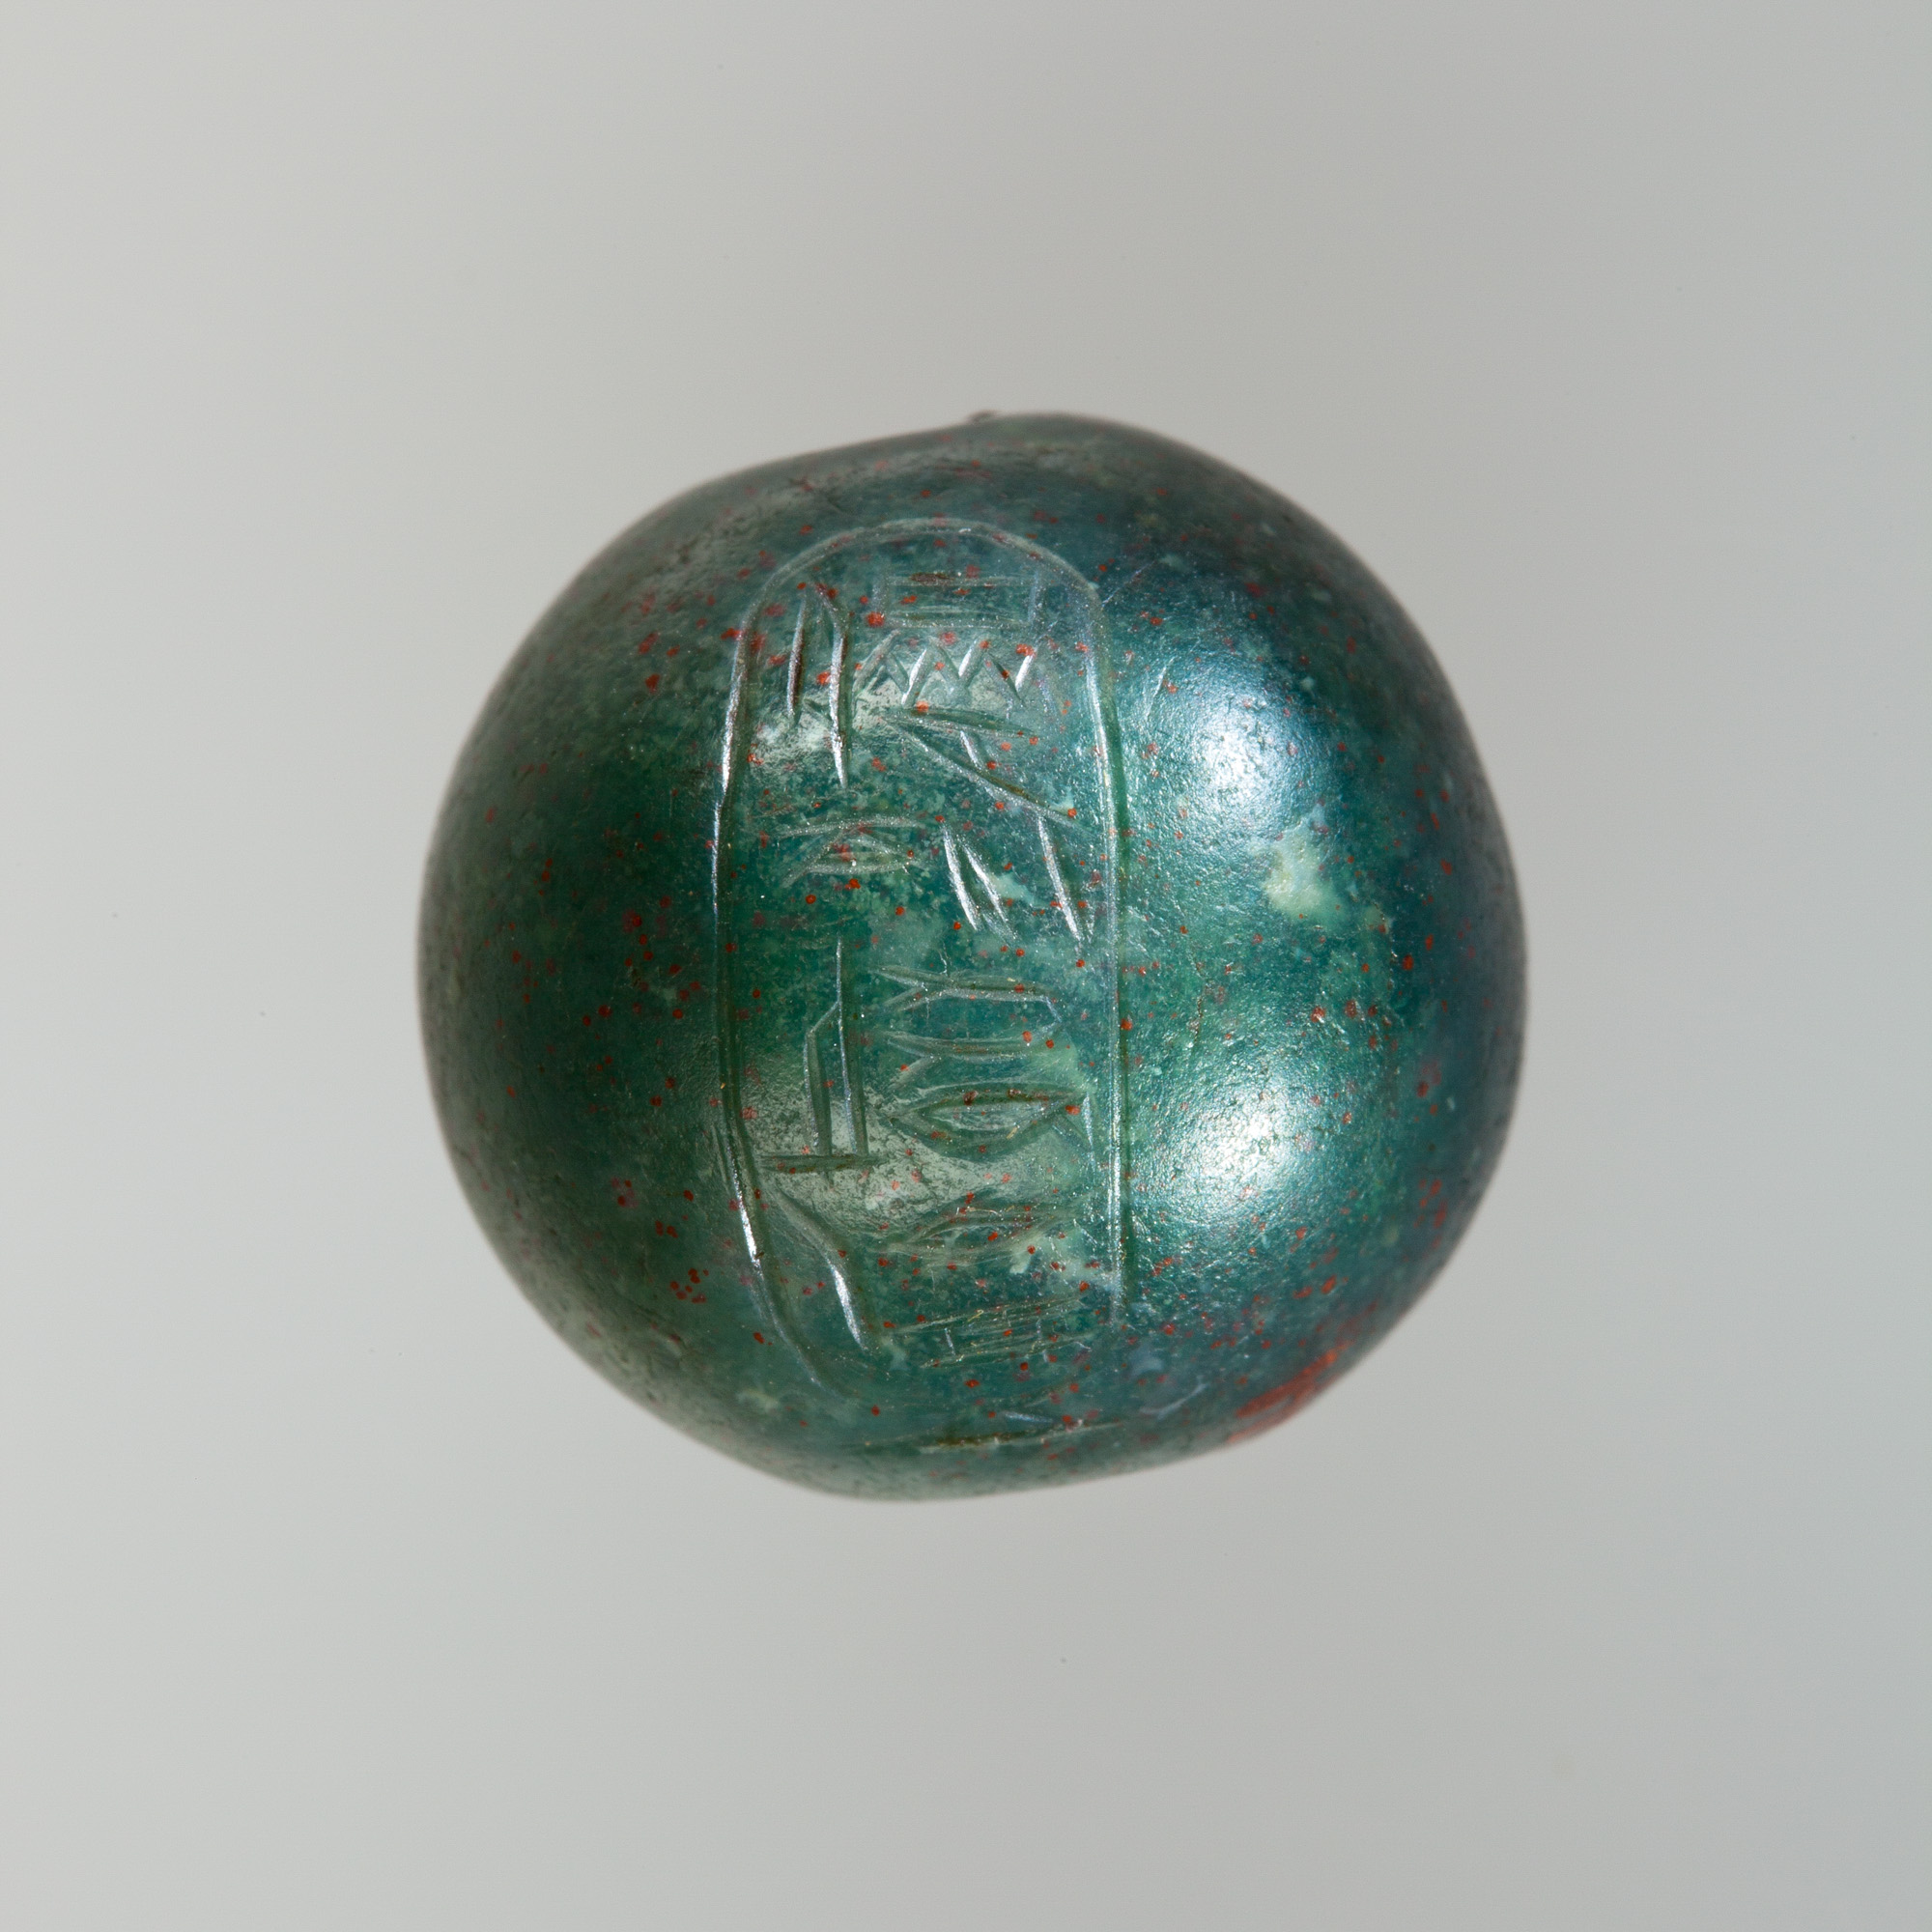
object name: bead, merytamun, queen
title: Bead Inscribed with the Name of Queen Merytamun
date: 1550-1295 BCE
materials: jasper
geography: egypt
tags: hieroglyphs